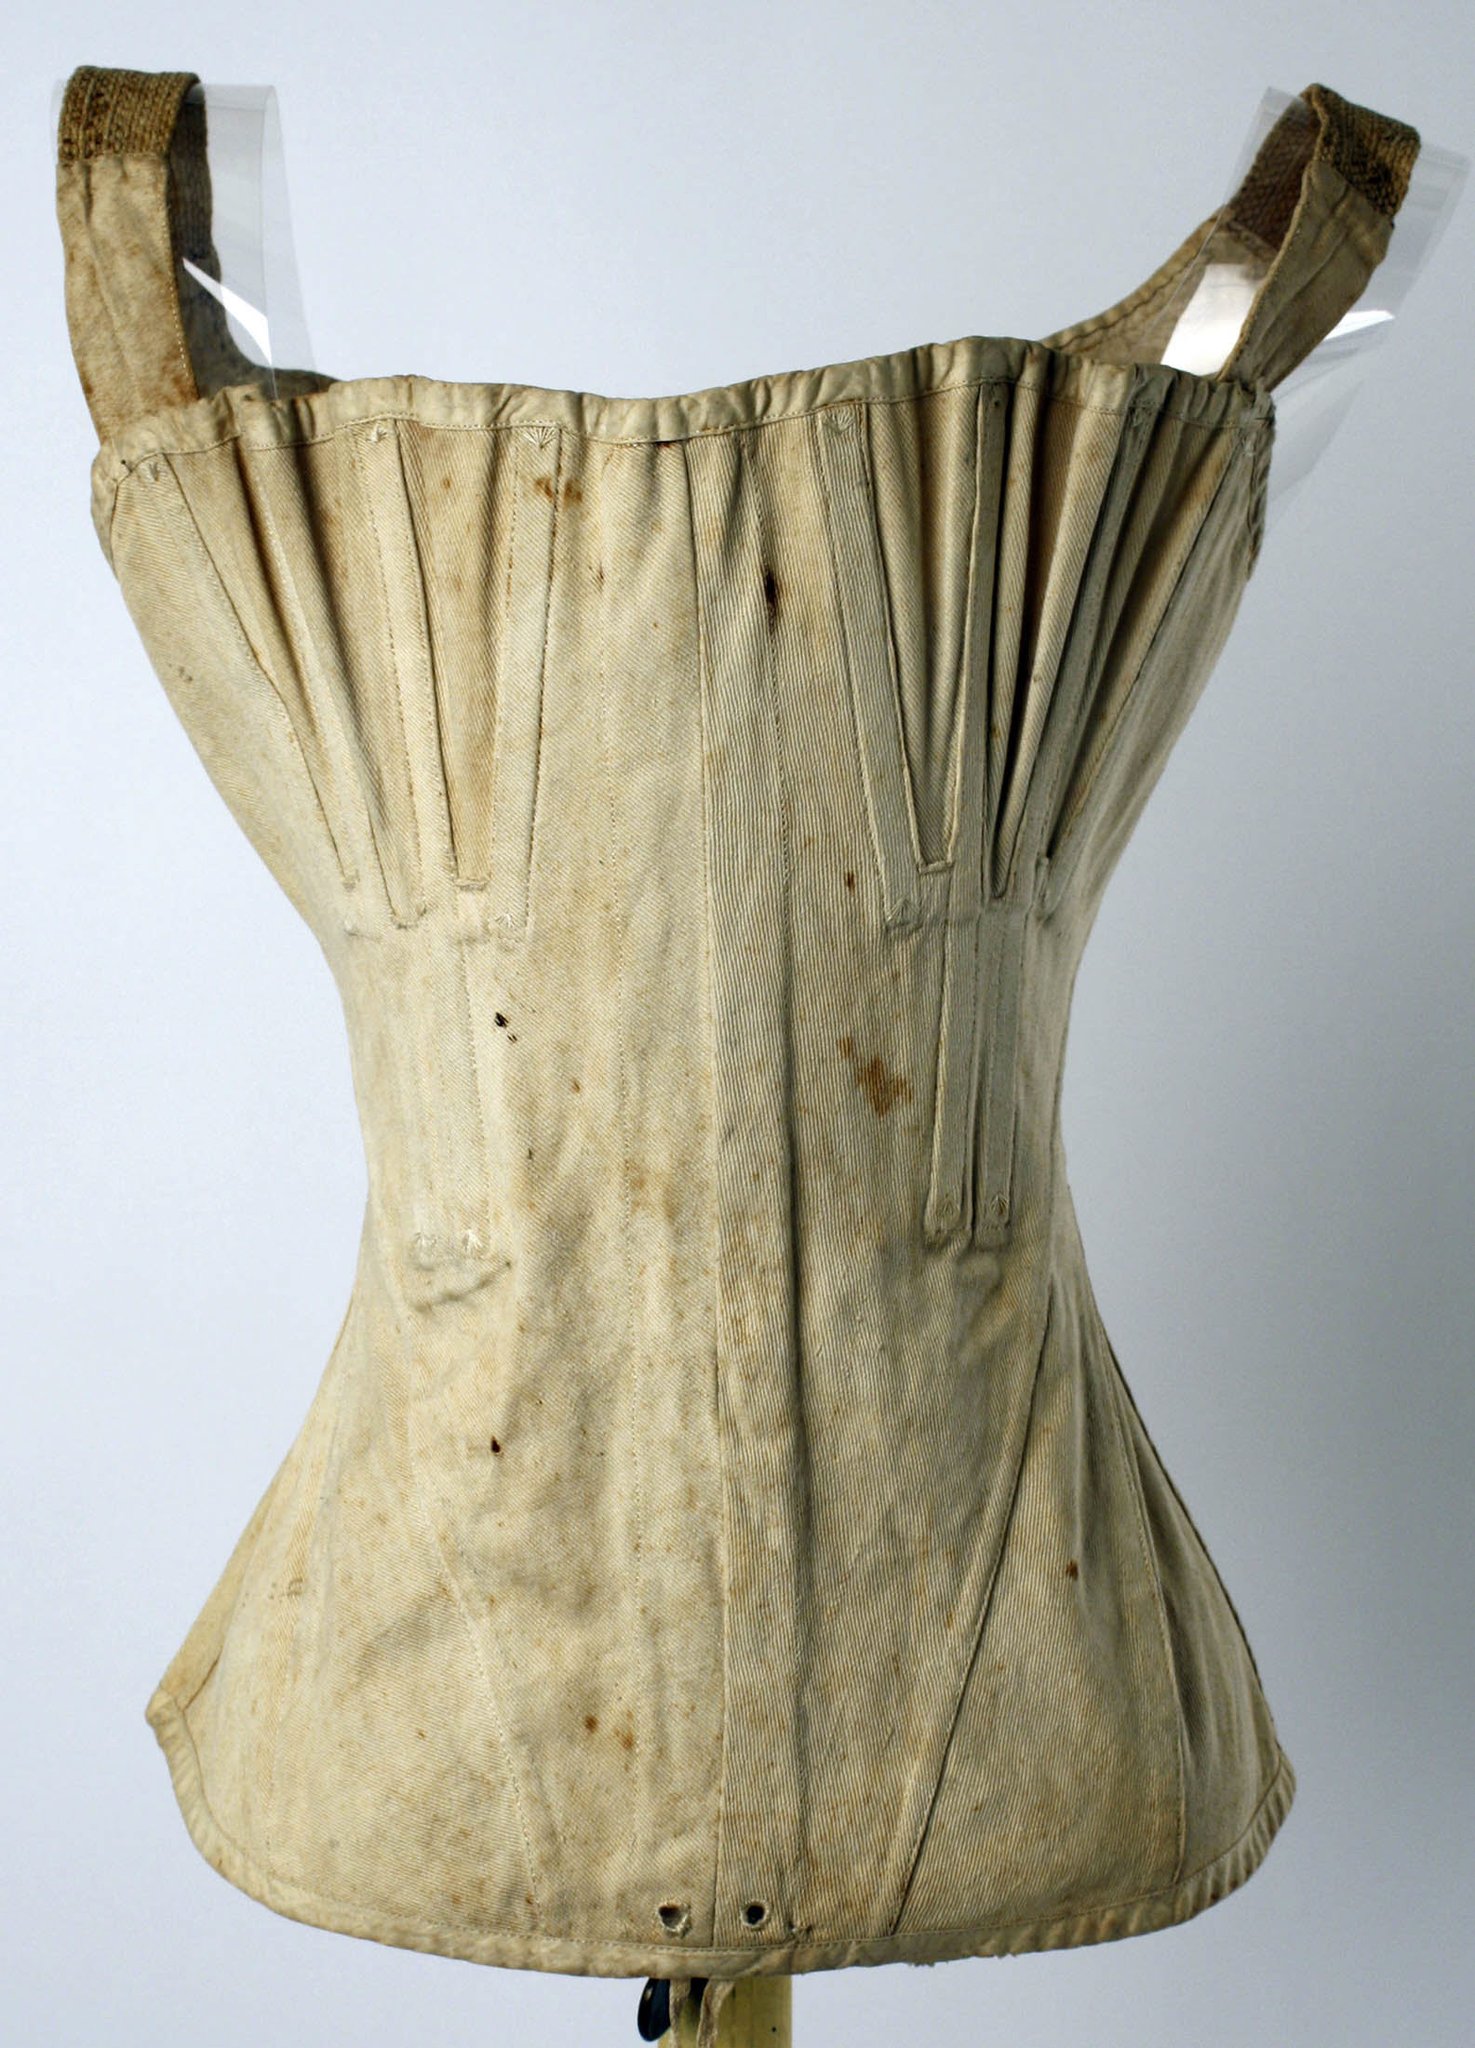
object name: corset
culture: american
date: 1833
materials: cotton